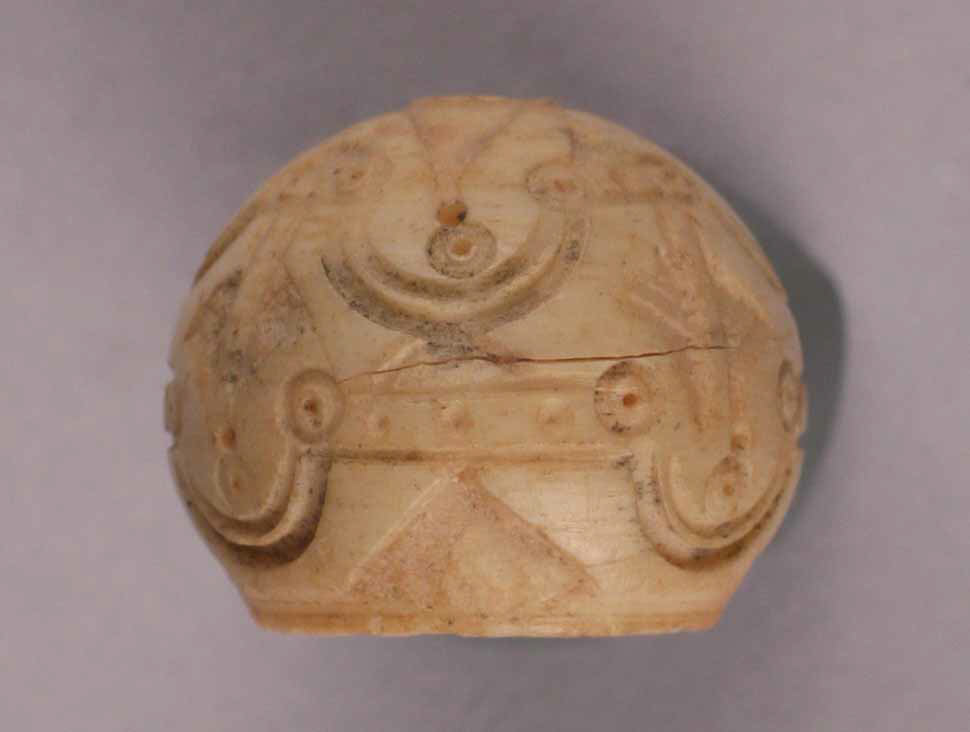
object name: button or bead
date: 801-1000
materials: bone, paint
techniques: incising, inlay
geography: iran